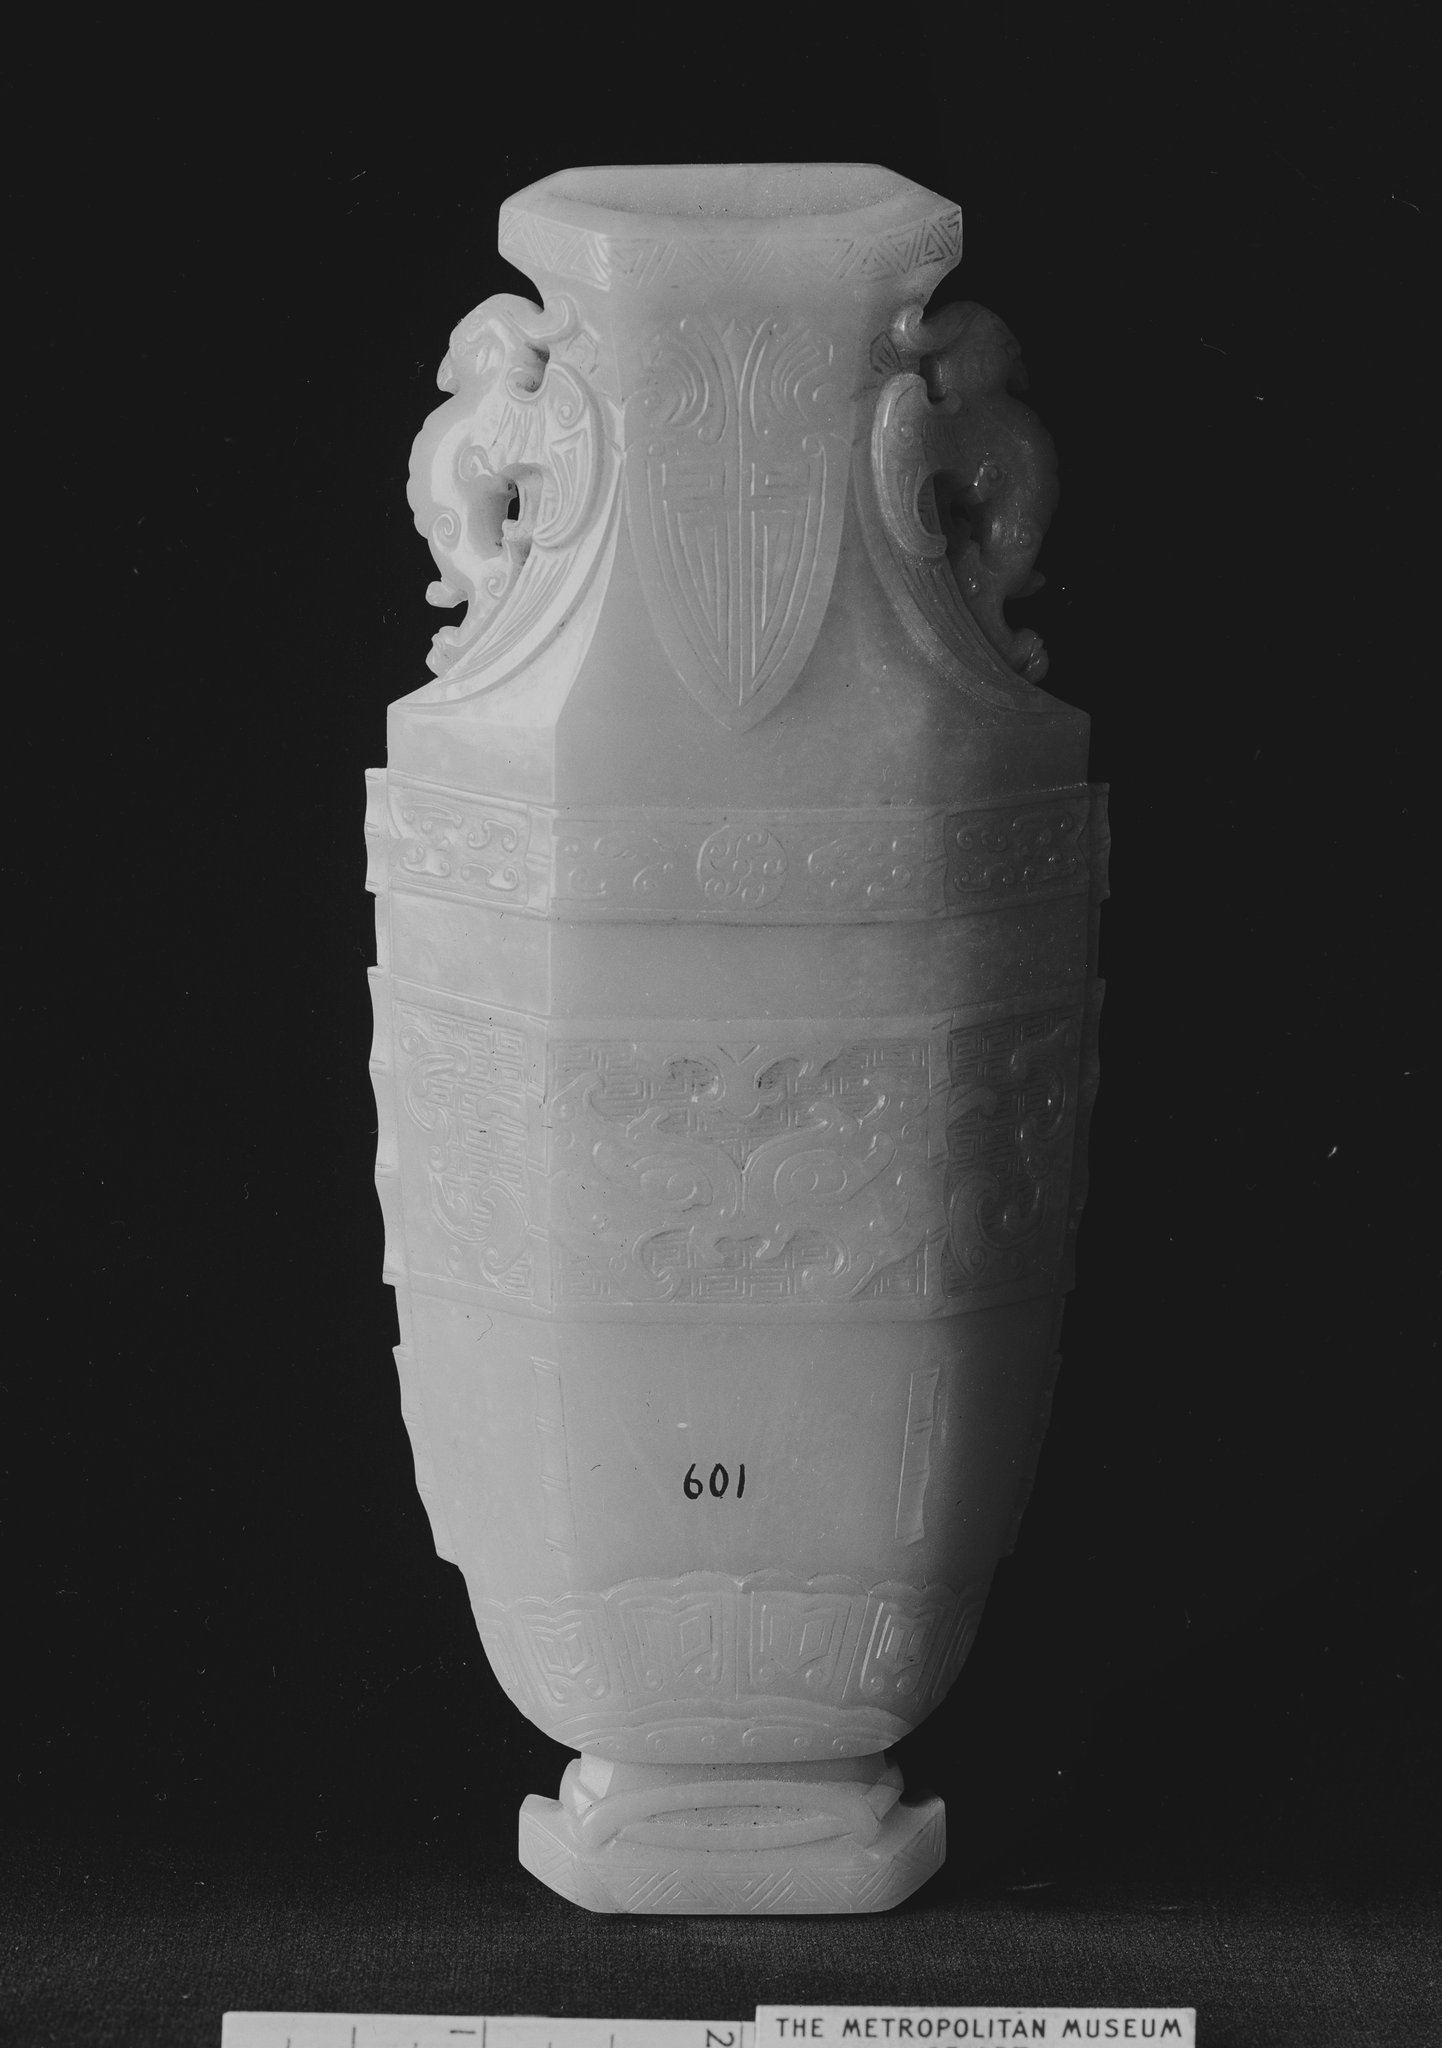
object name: wall vase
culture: chinese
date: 1701-1800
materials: jade